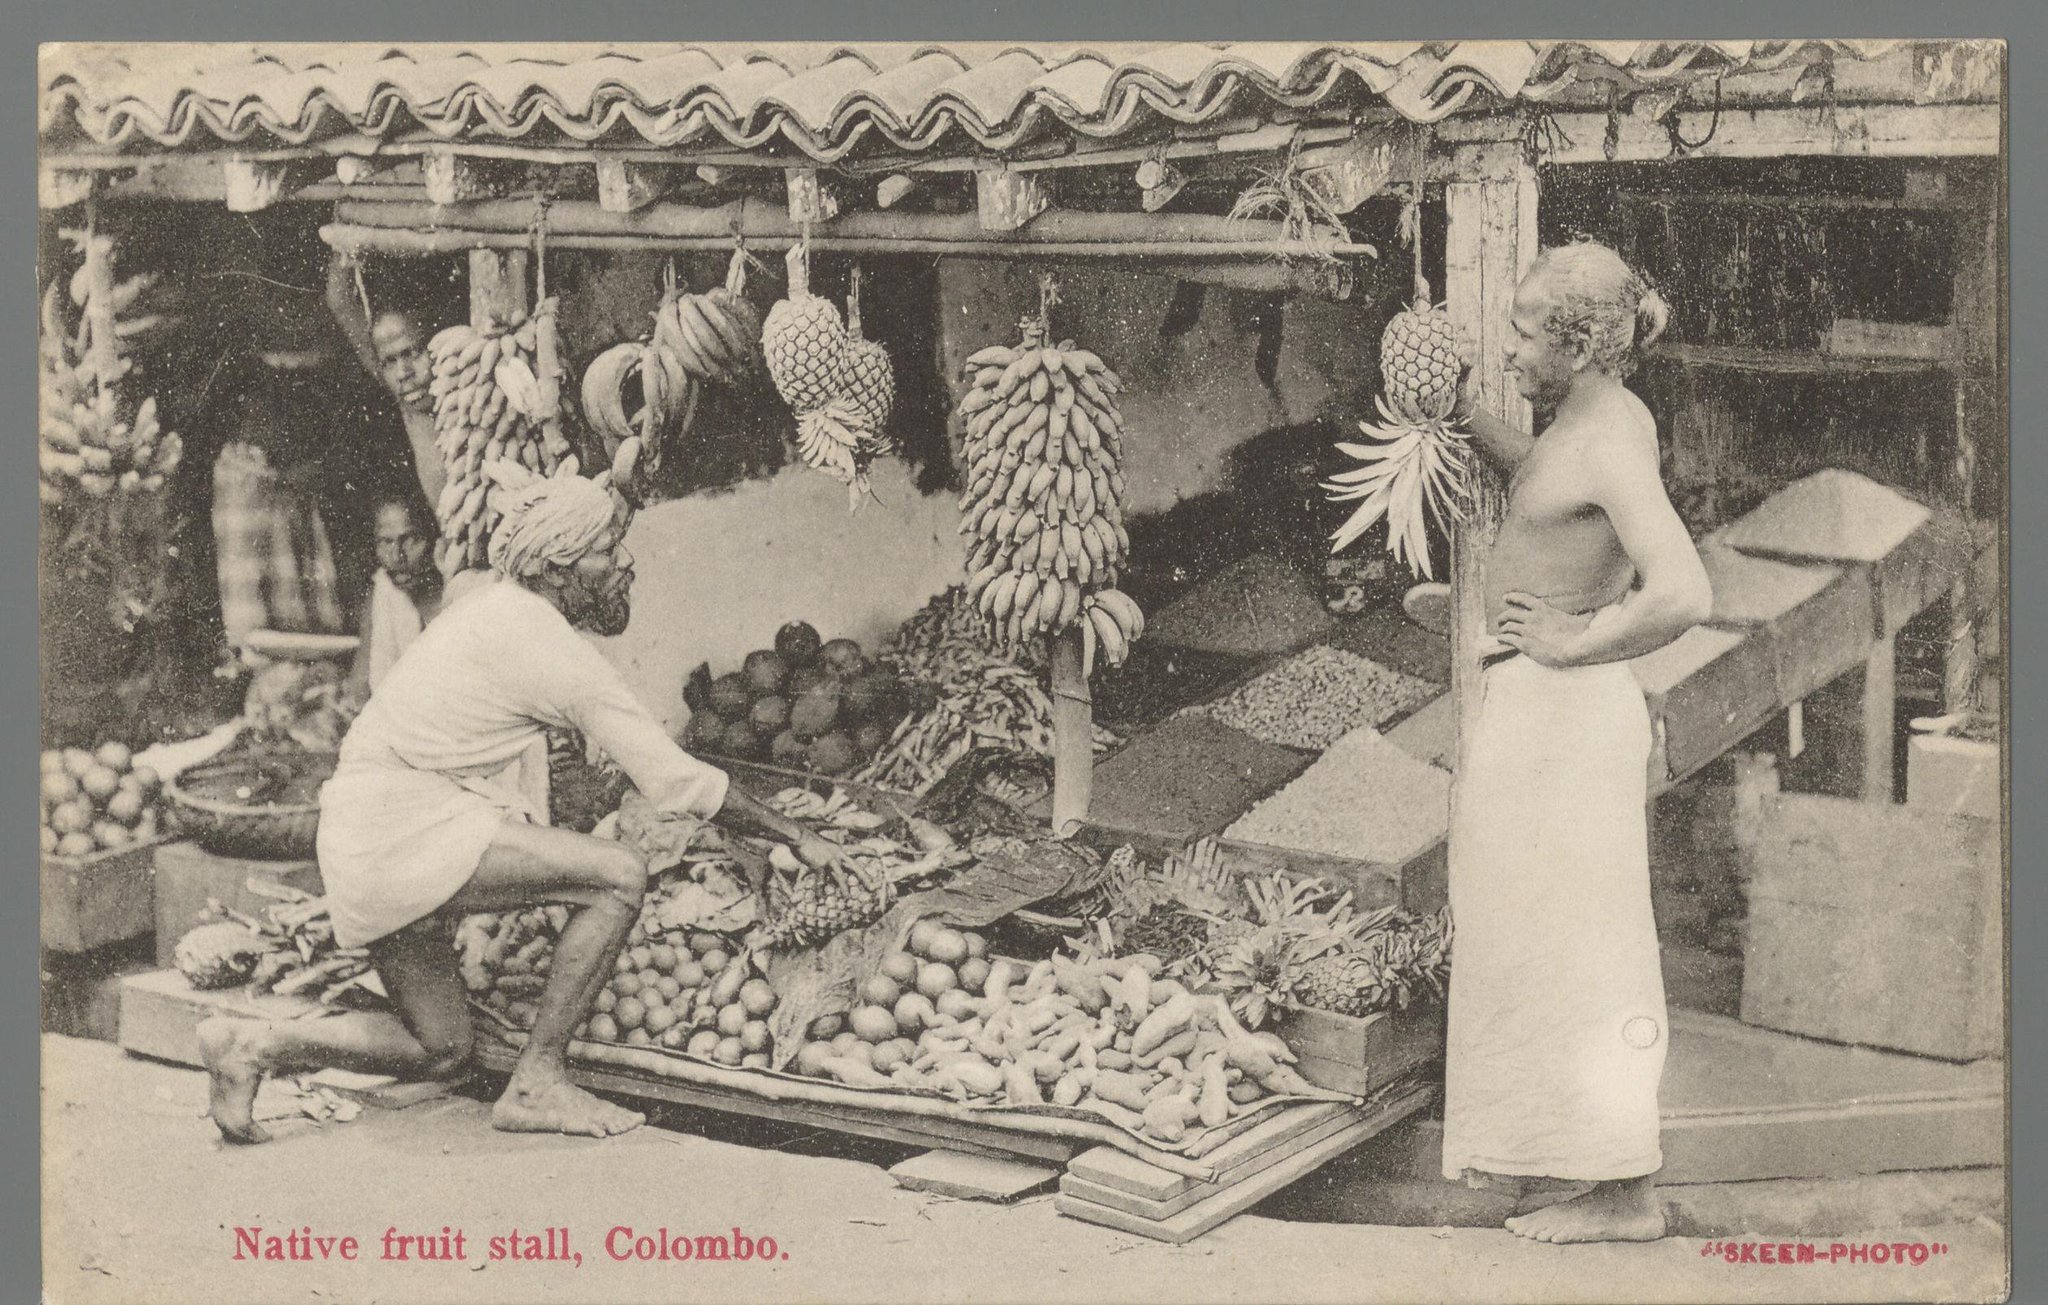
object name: photomechanical print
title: Native fruit stall, Colombo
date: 1902-1903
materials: cardboard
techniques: photograph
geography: colombo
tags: stall, booth (~ market), fruits